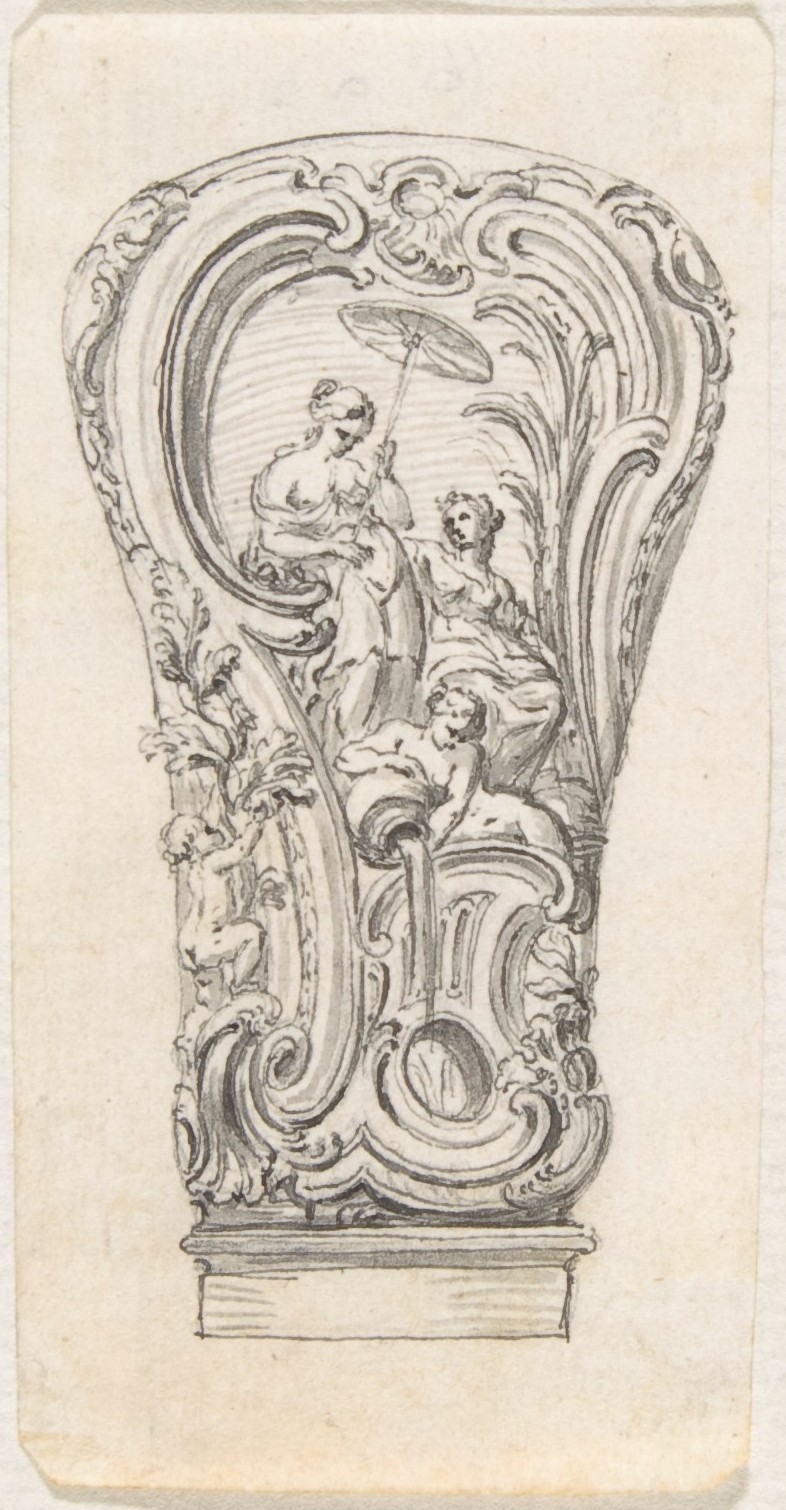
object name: drawing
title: Design for a Repouseé Cane Handle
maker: juste aurèle meissonnier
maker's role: artist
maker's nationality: french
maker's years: 1695-1750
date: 1675-1750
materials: graphite, ink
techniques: brush, pen, drawing, wash